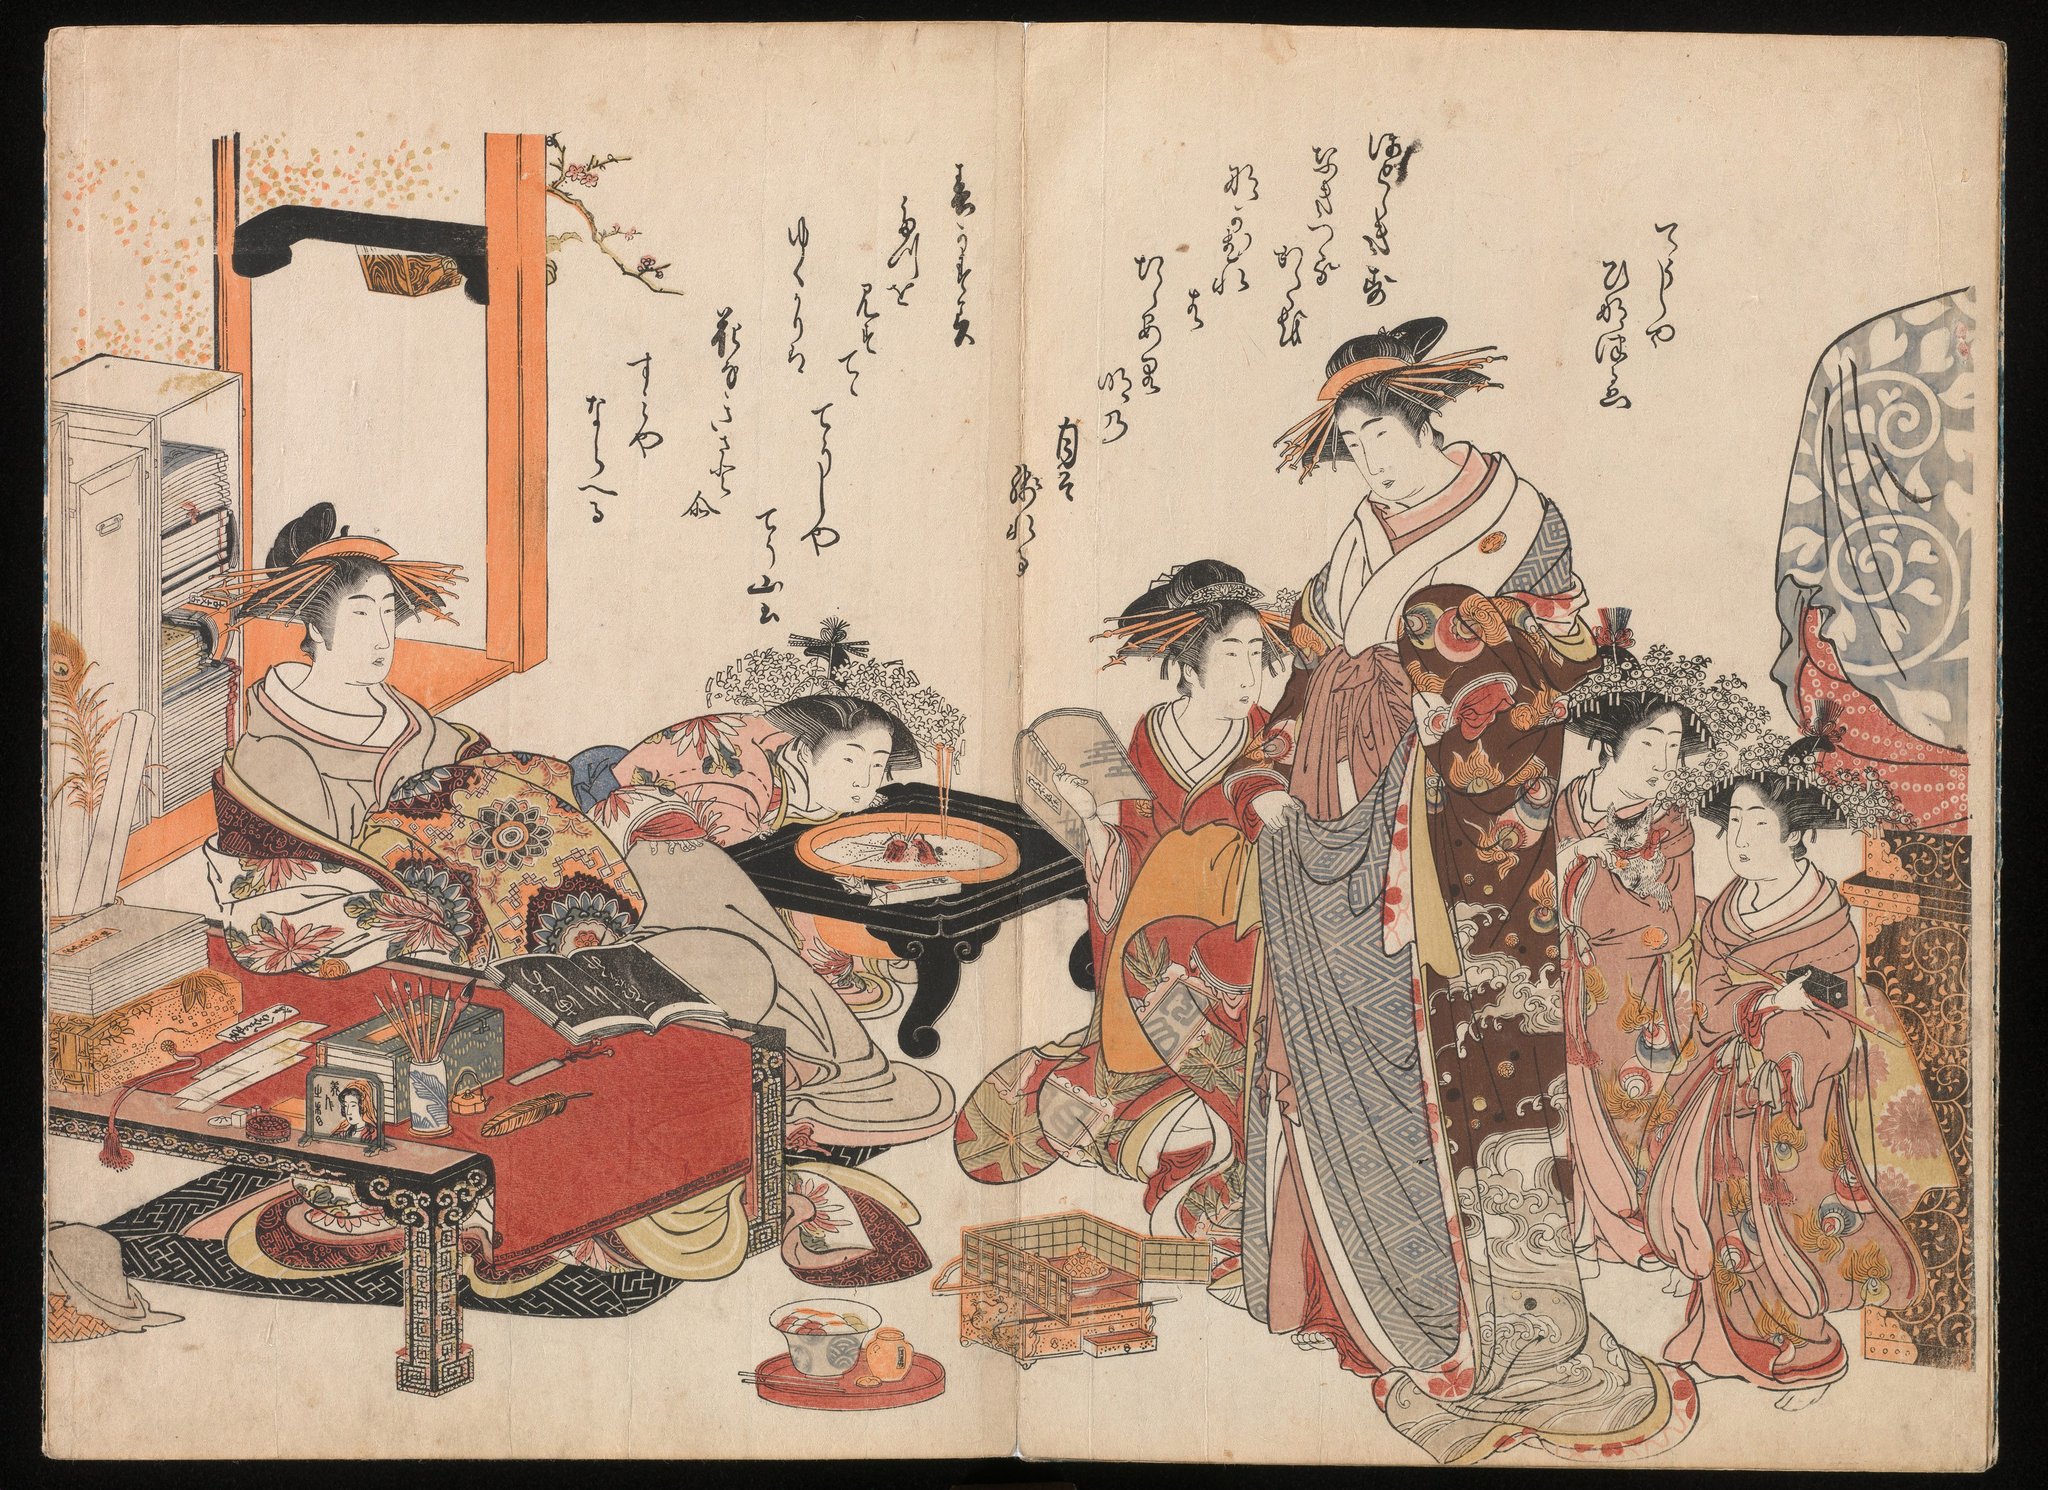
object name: illustrated book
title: A New Record Comparing the Handwriting of the Courtesans of the Yoshiwara (Yoshiwara keisei shin bijin jihitsu kagami) 吉原傾城新美人自筆鏡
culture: japanese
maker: kitao masanobu (santō kyōden) 北尾政演 (山東京伝)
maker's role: artist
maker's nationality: japanese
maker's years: 1761-1816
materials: ink, paper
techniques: woodblock print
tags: women